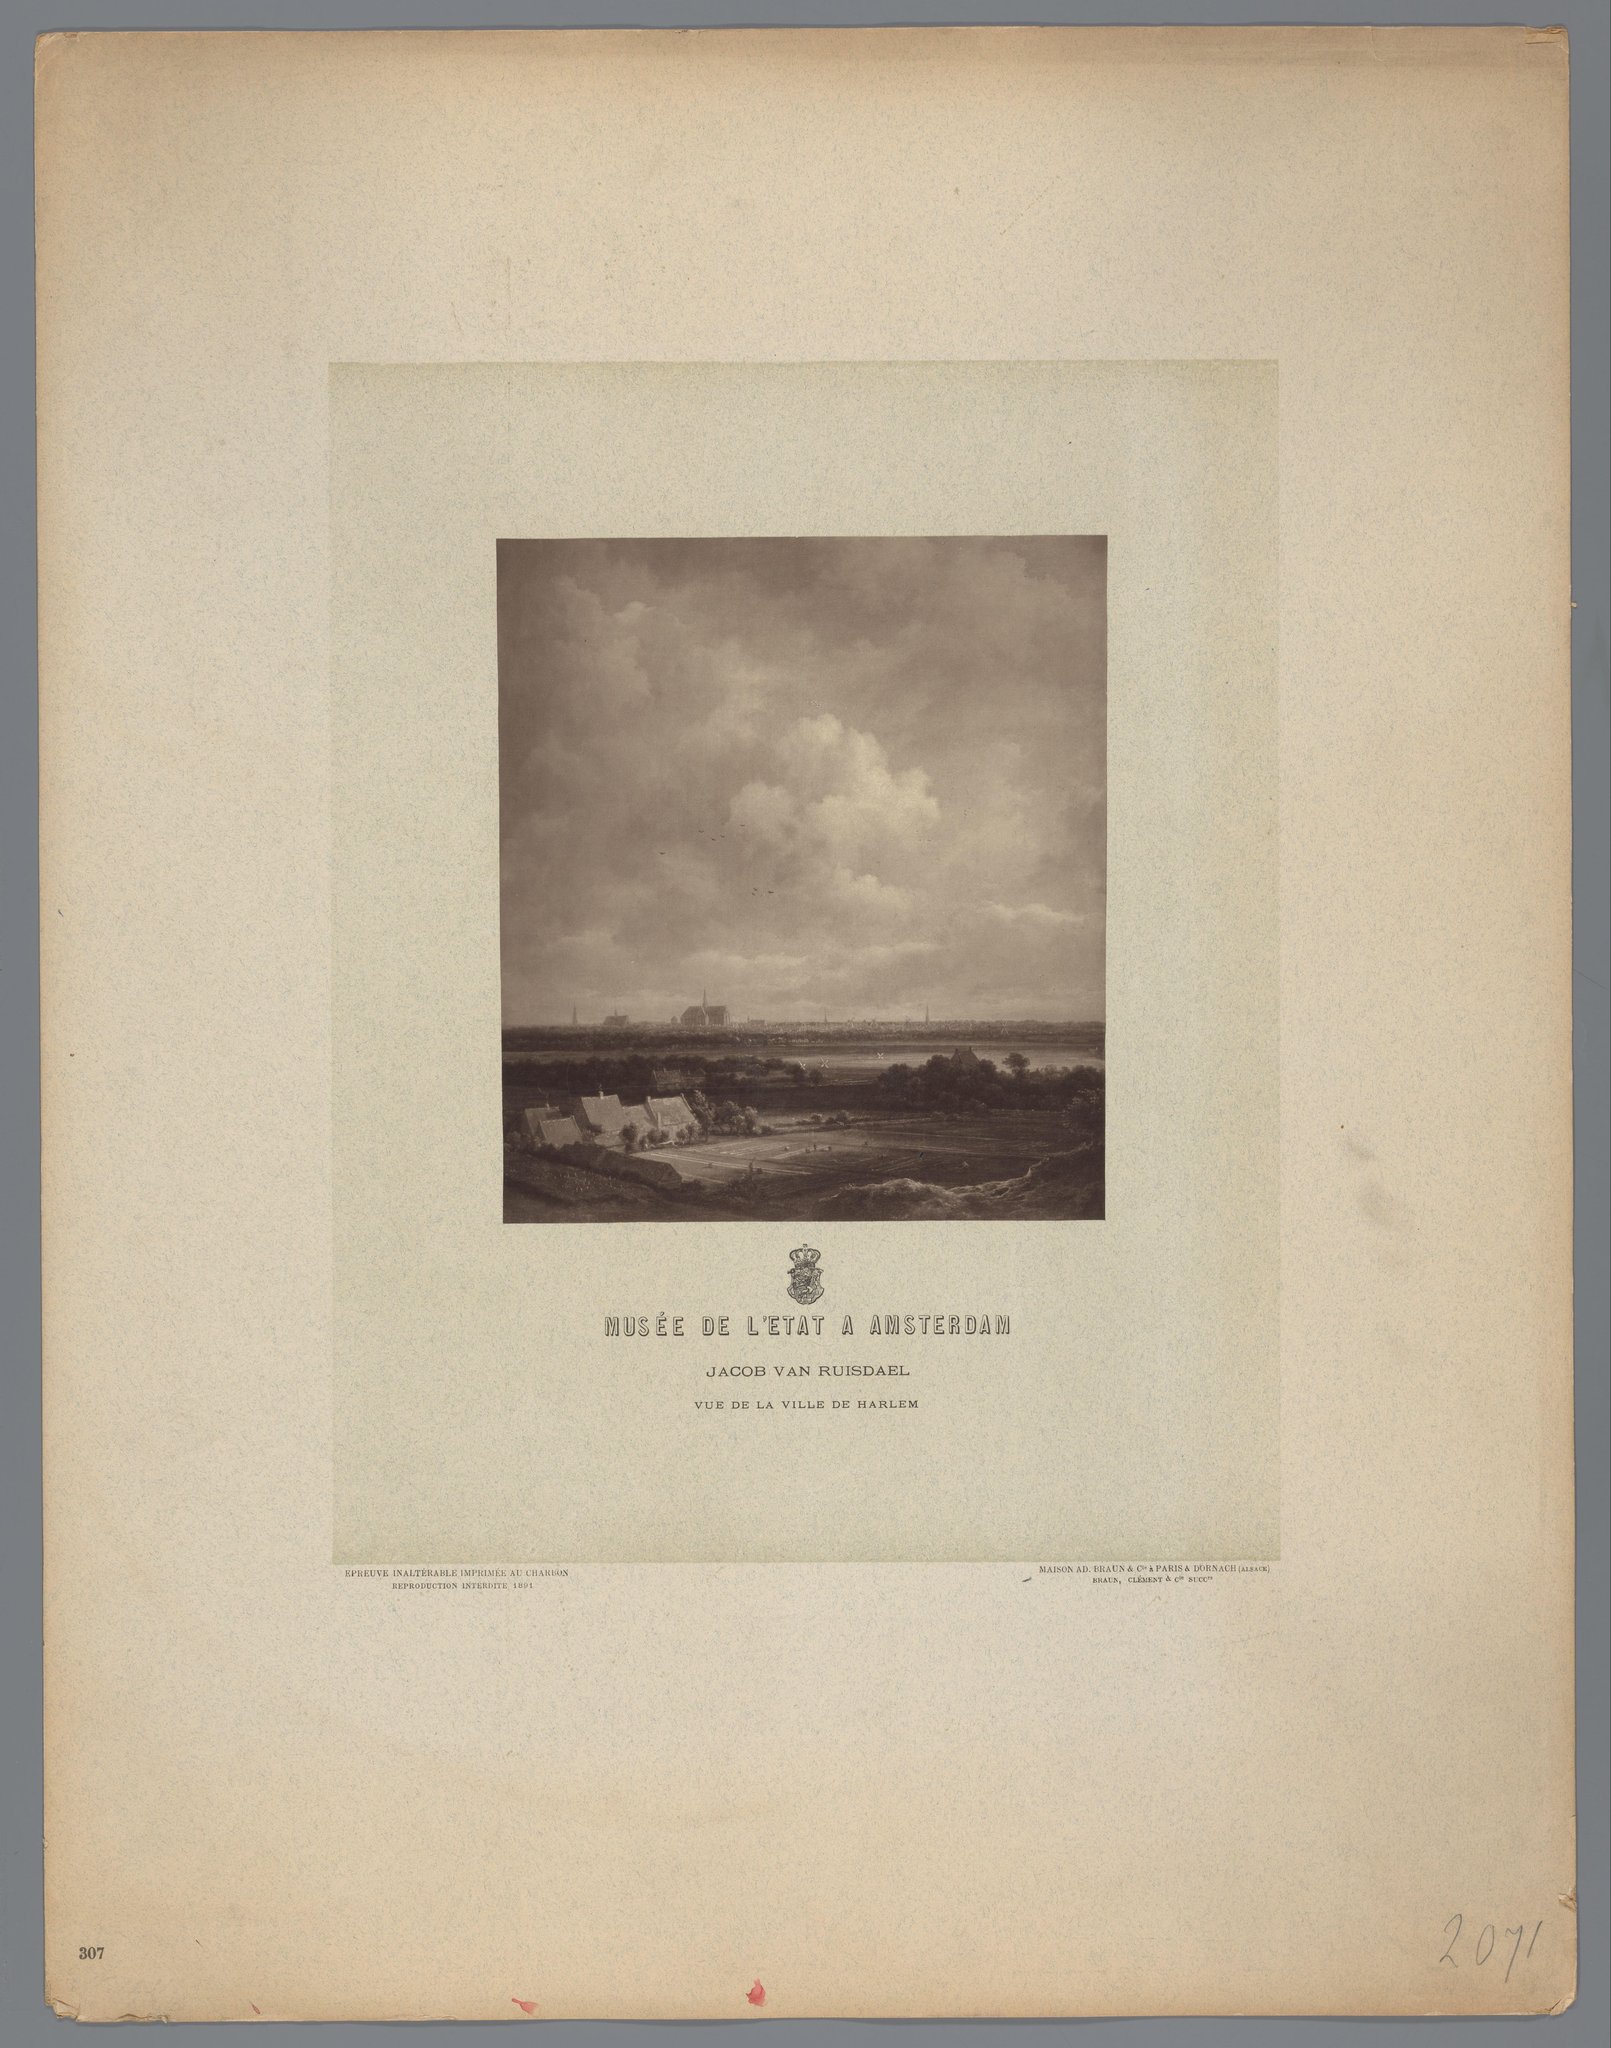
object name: photograph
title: Fotoreproductie van een schilderij van Jacob van Ruisdael, 'Gezicht op Haarlem uit het noordwesten, met de blekerijen op de voorgrond' (coll. Rijksmuseum)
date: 1891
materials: cardboard, paper, photographic support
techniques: carbon print